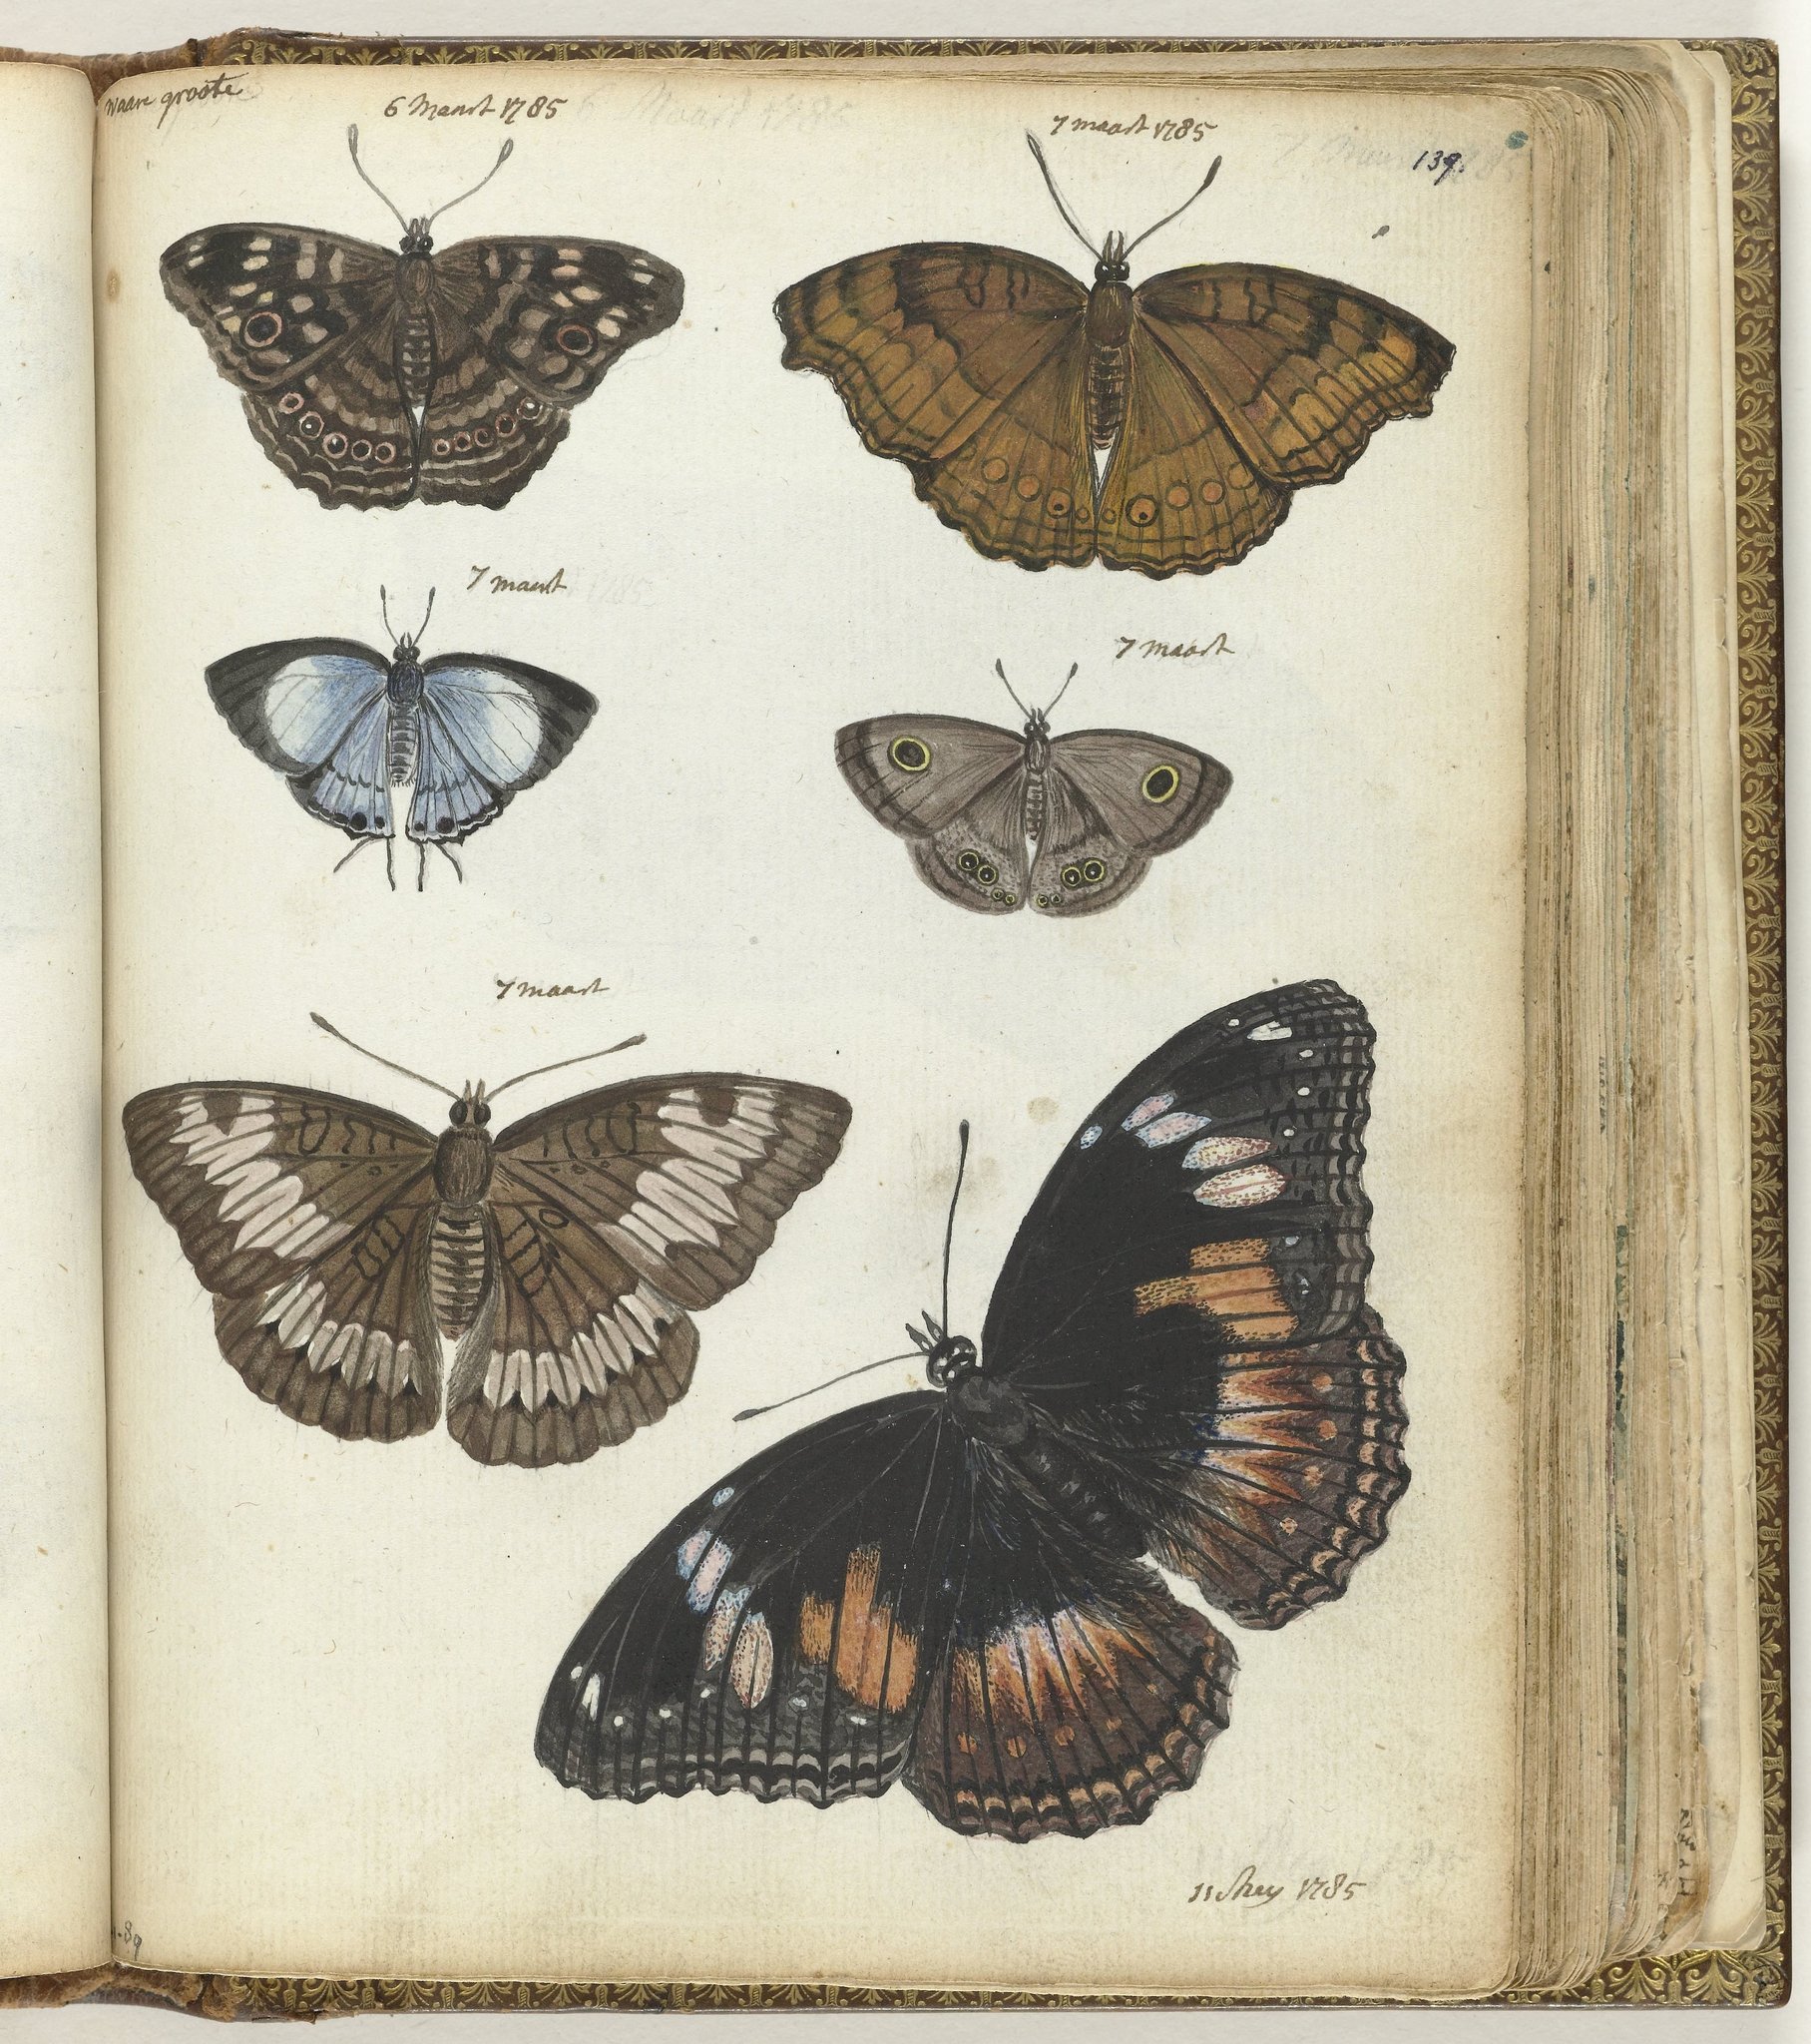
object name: drawing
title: Indische vlinders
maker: jan brandes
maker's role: draughtsman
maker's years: 1743-1808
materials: paper, pencil, watercolor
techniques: brush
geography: jakarta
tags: insects: butterfly, indonesia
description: Kleurtekening van een aantal Javaanse vlinders en motachtigen. Op ware grootte. Met opschrift. Onderdeel uit het schetsboek van Jan Brandes, dl. 1 (1808), p. 139.